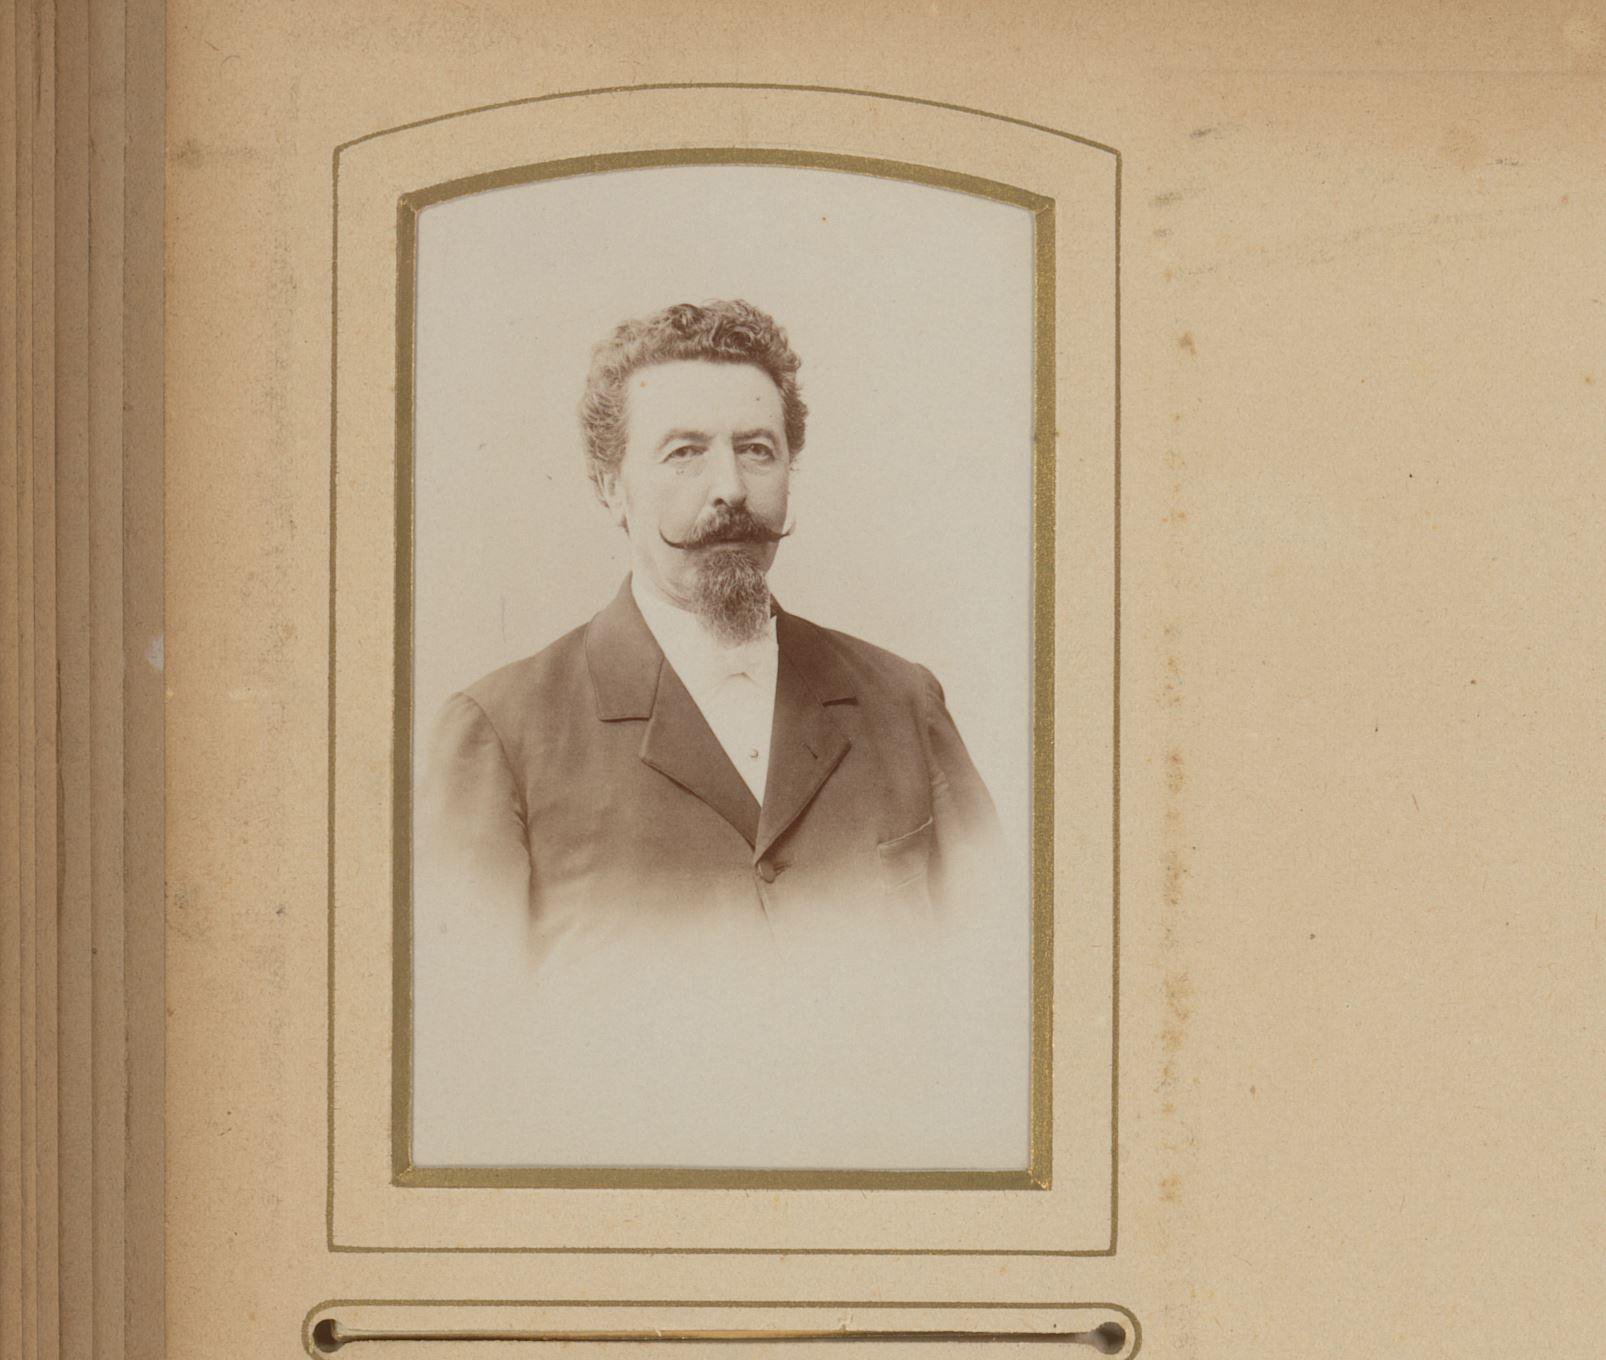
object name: carte de visite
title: Portret van een man met snor en sik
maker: edouard fabronius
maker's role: fotograaf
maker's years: 1847-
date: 1894-1901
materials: cardboard, photographic support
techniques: albumen print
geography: brussels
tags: moustache, historical persons, beard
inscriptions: inscription: ‘MEDAILLE D'OR/ A L'EXPOSITION UNIVERSELLE/ Anvers 1894./ E. Fabronius./ Photographe/ Bruxelles,/ 11, Rue Neuve/ Les clichés sont conservés.’